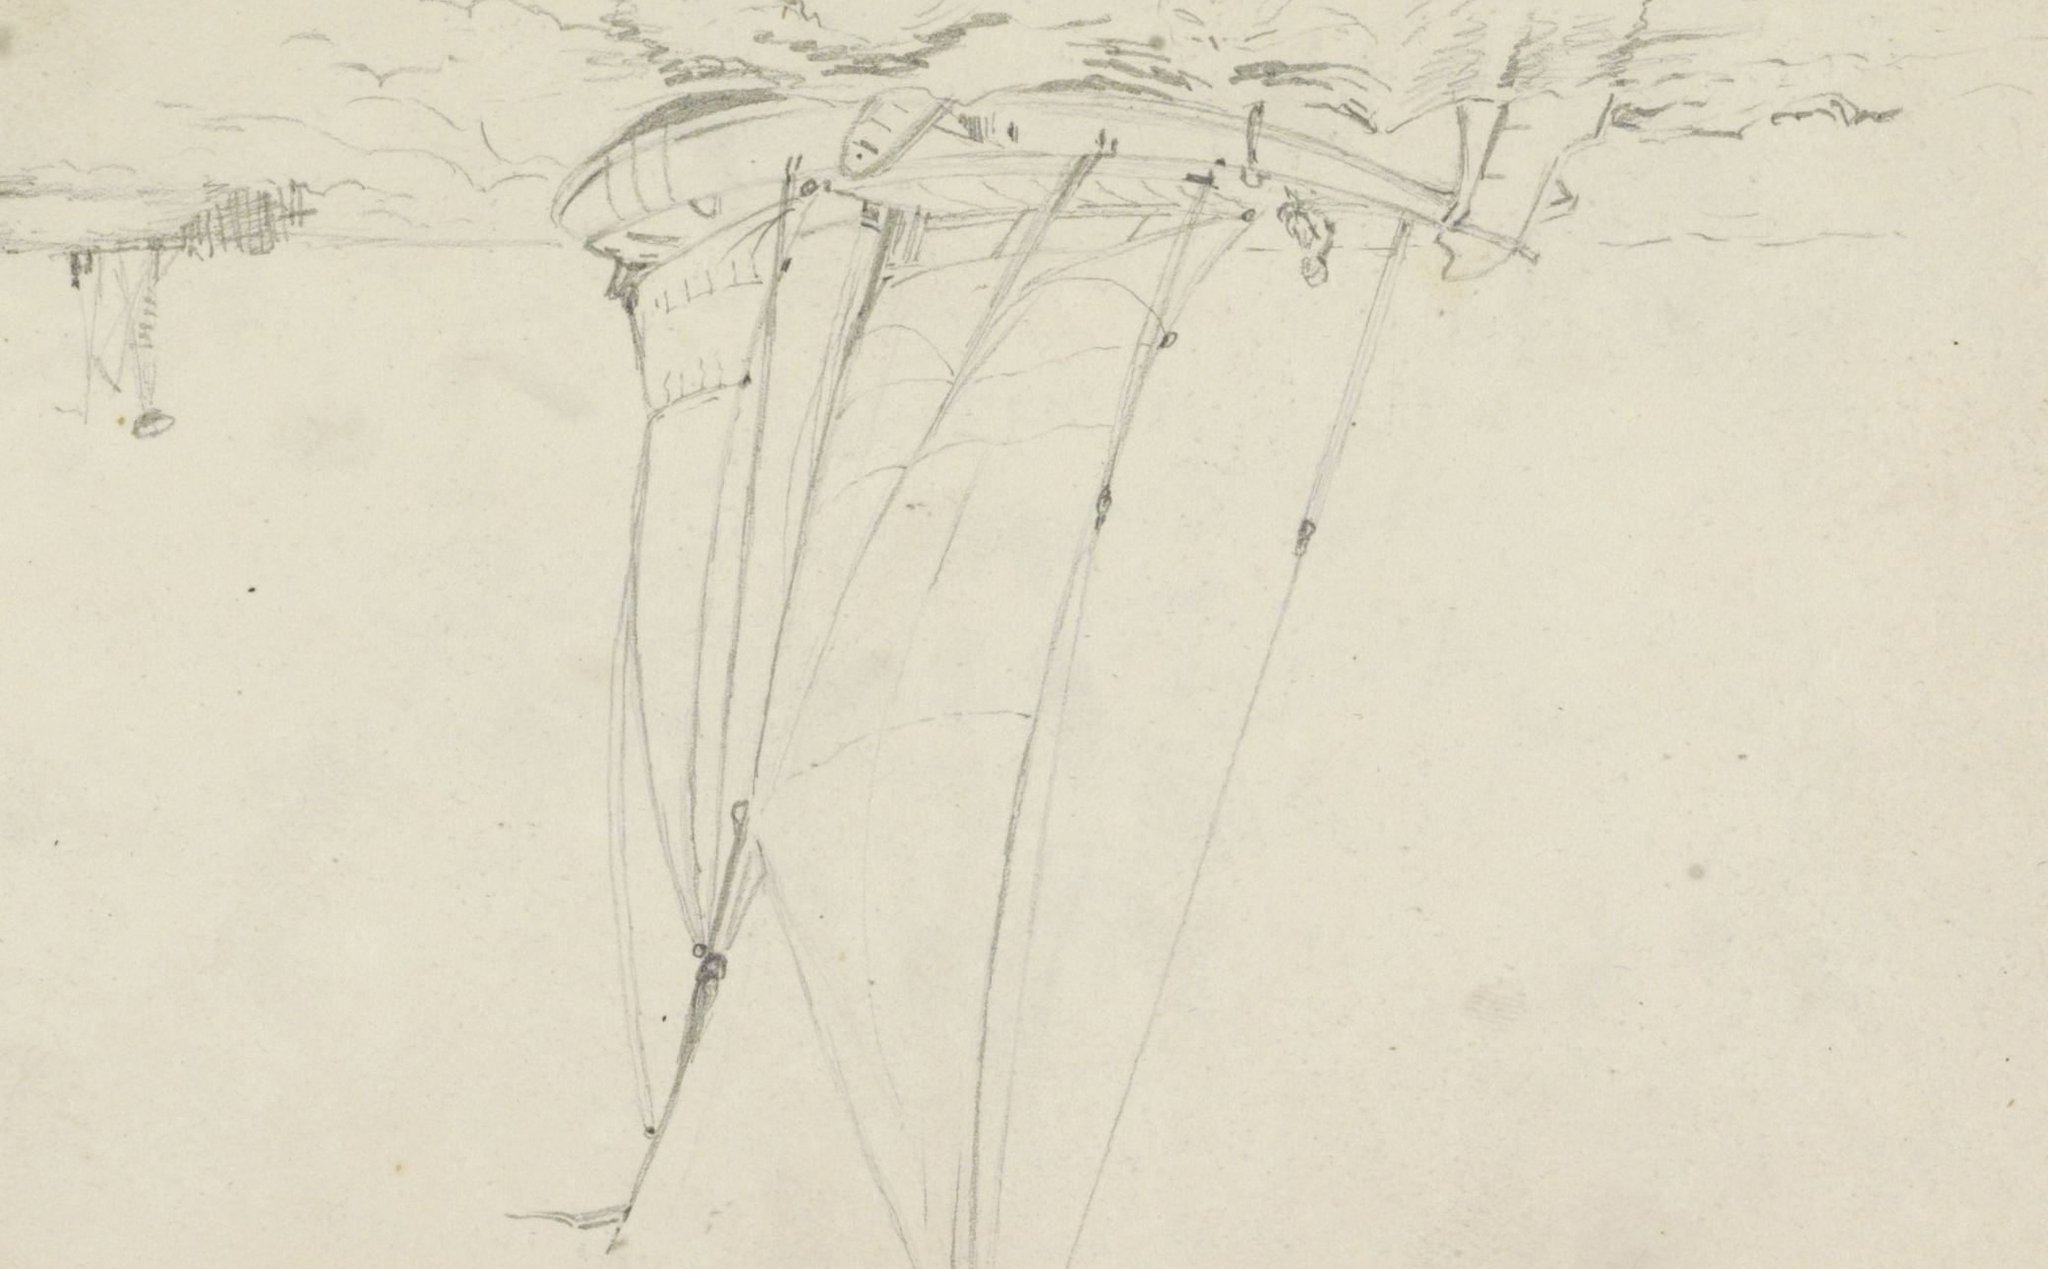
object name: sketchbook leaf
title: Zeilschepen op open water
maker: adrianus eversen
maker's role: draughtsman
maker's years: 1818-1897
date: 1828-1897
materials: paper, pencil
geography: netherlands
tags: sailing-ship, sailing-boat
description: Vooraan een zeilschip op open water. Een man bedient de helmstok. In de verte een tweede zeilschip. Blad 5 recto uit een schetsboek met 27 bladen.